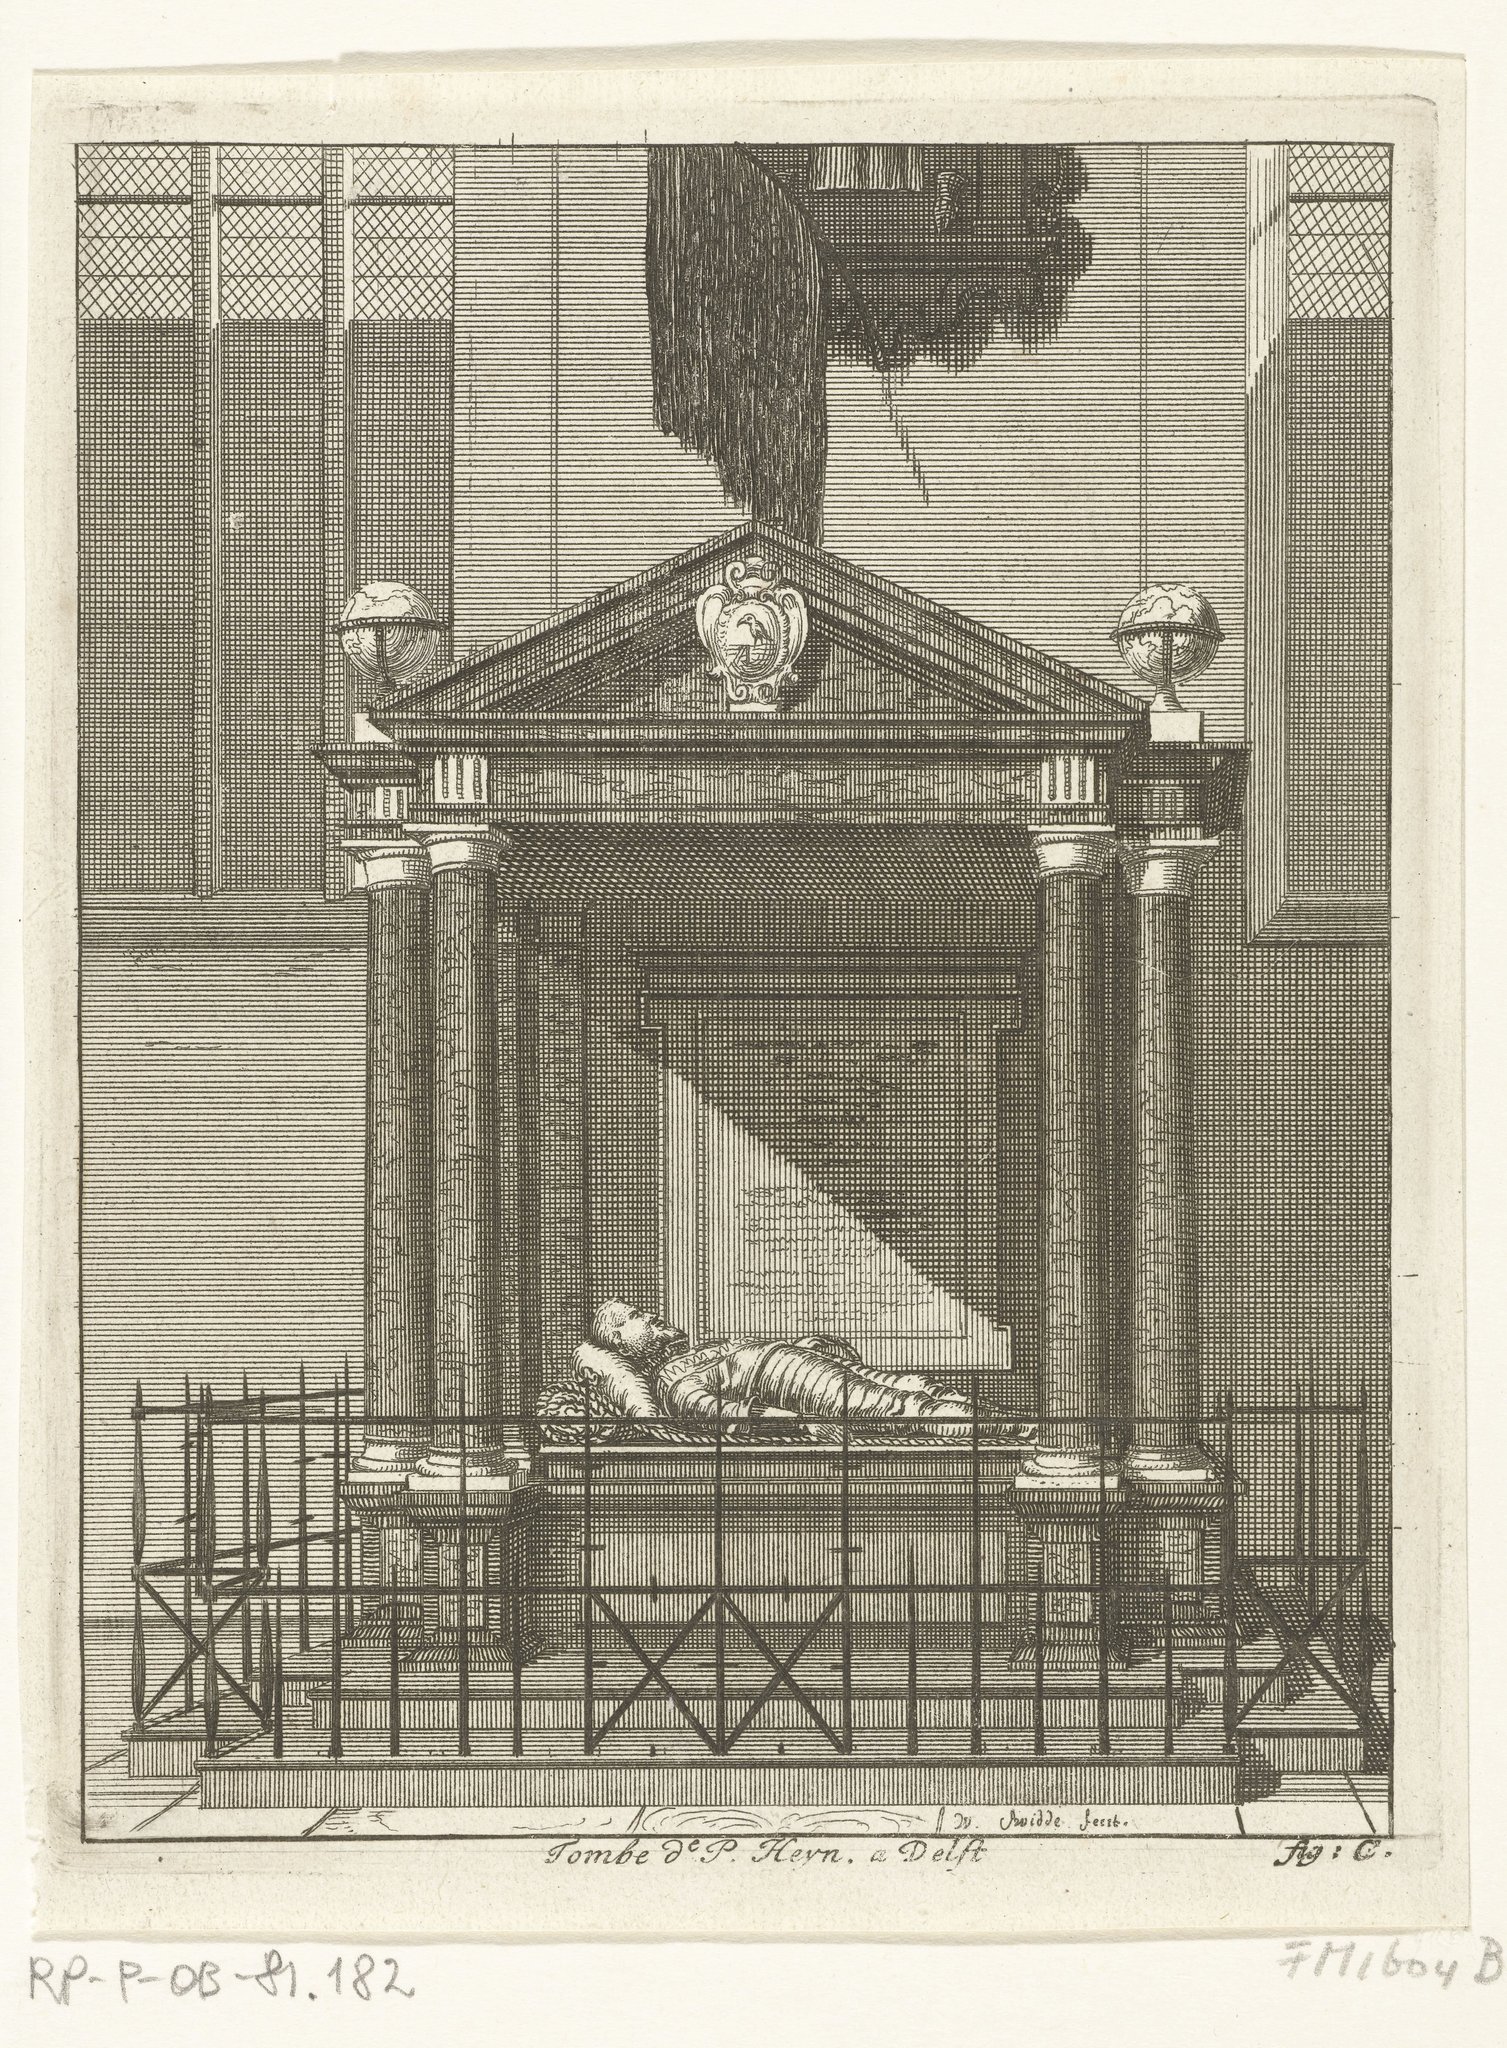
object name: print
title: Graftombe van Piet Hein te Delft, 1629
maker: willem swidde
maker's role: print maker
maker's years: 1660-1697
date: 1688-1690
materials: paper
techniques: etching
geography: northern netherlands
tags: delfshaven, grave-building, monumental tomb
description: Gebruikt als illustratie in: Nederlands helden-tooneel, vertoonende zeer cierlijk in koper gesneeden alle de grafsteden, opgerecht ter eere der dappere mannen, welke hun leven ten dienste des vaderlands opgeofferd hebben, P. Mortier, Amsterdam 1690. Niet in Frederik Muller; door het RPK toegevoegd nummer. Kopie naar de prent van C. Decker (FMH 1604Ba).